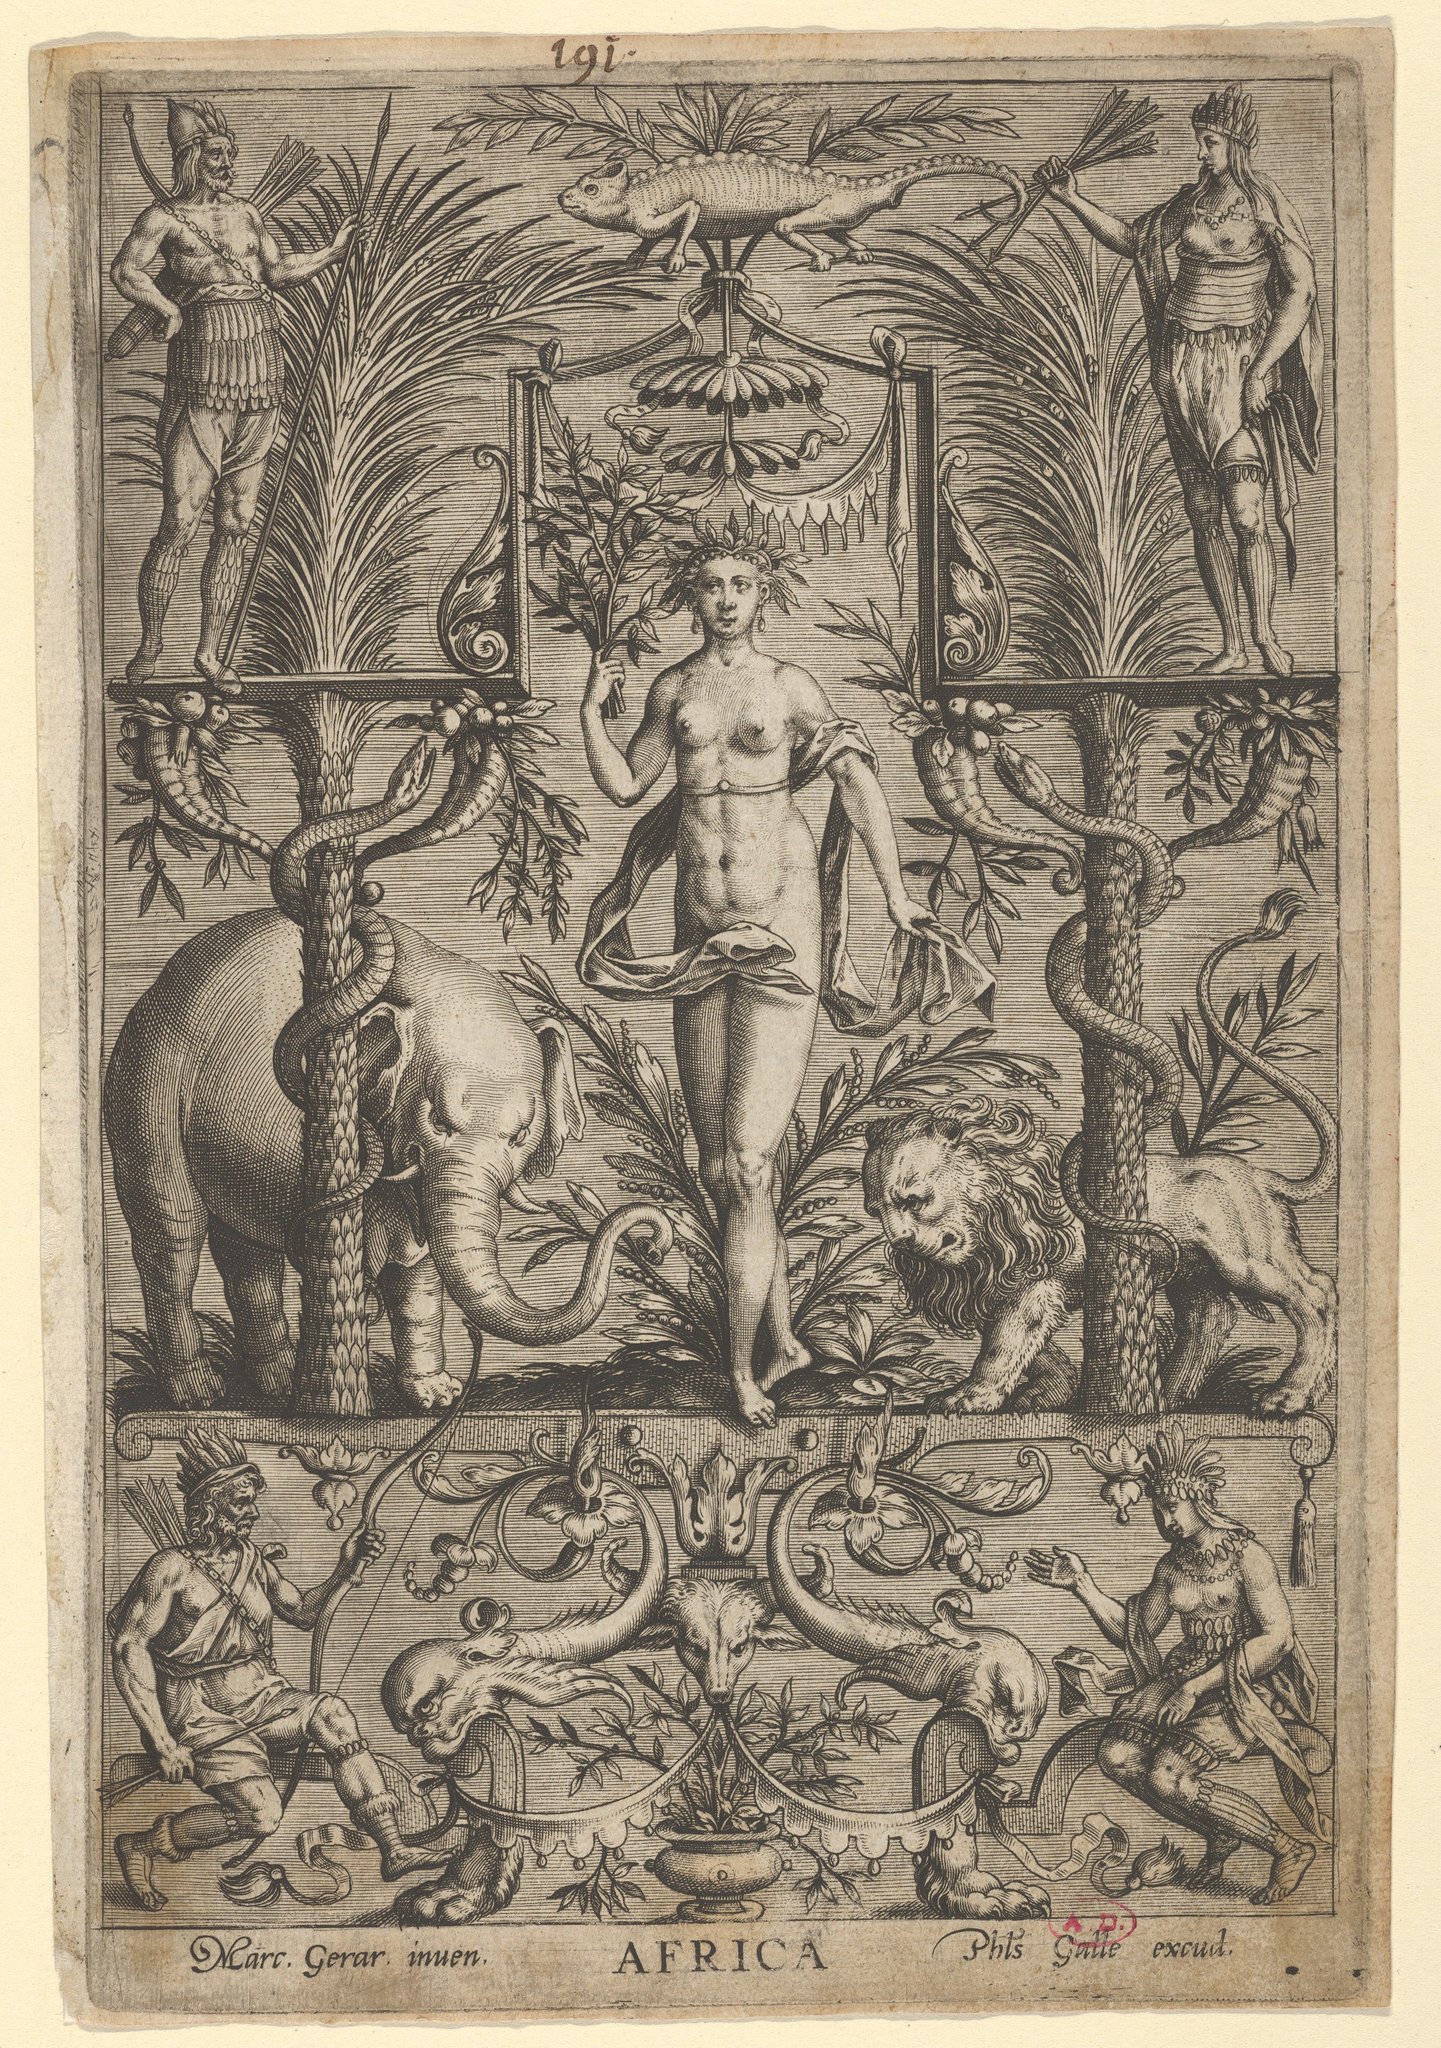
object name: print ornament architecture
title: Allegory of Africa, from "The Four Continents"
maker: marcus gheeraerts the elder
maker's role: artist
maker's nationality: flemish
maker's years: 1510-1600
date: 1590-1600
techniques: engraving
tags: men,female nudes,elephants,lions,snakes